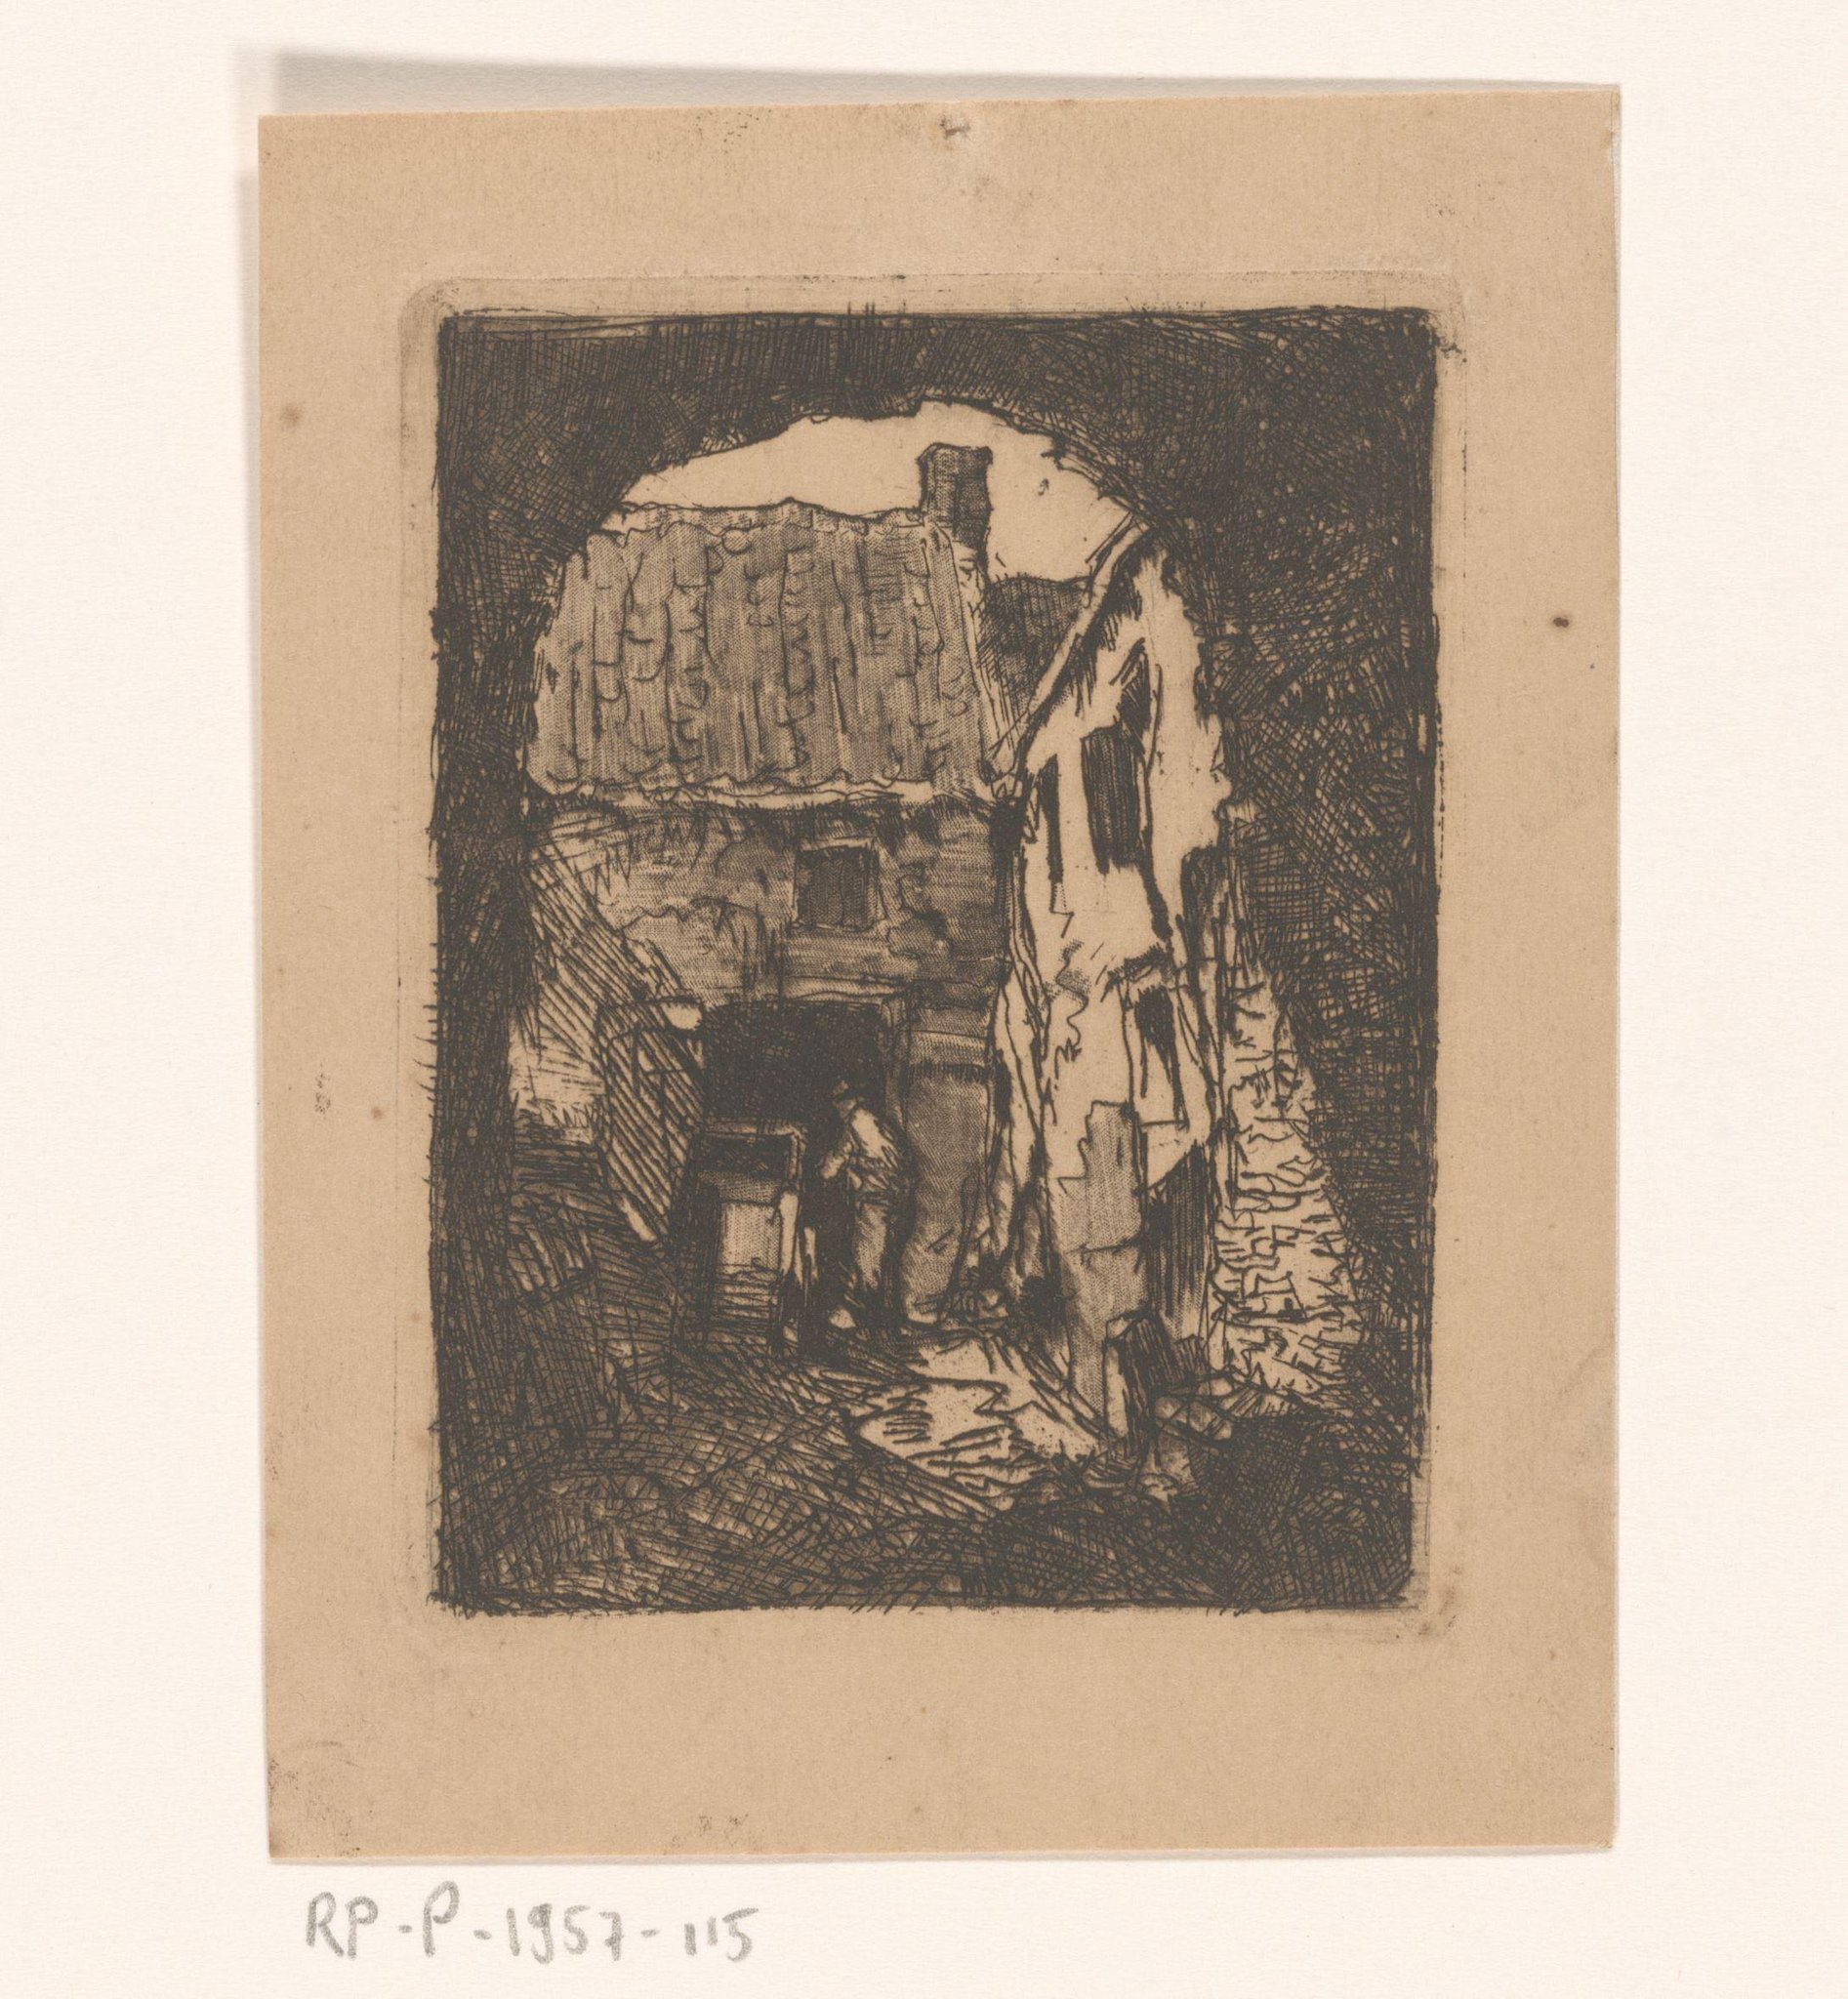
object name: print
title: Binnenplaats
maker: chris van der windt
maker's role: print maker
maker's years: 1877-1952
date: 1887-1952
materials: paper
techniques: etching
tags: courtyard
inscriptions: collector's mark: Lugt 2228